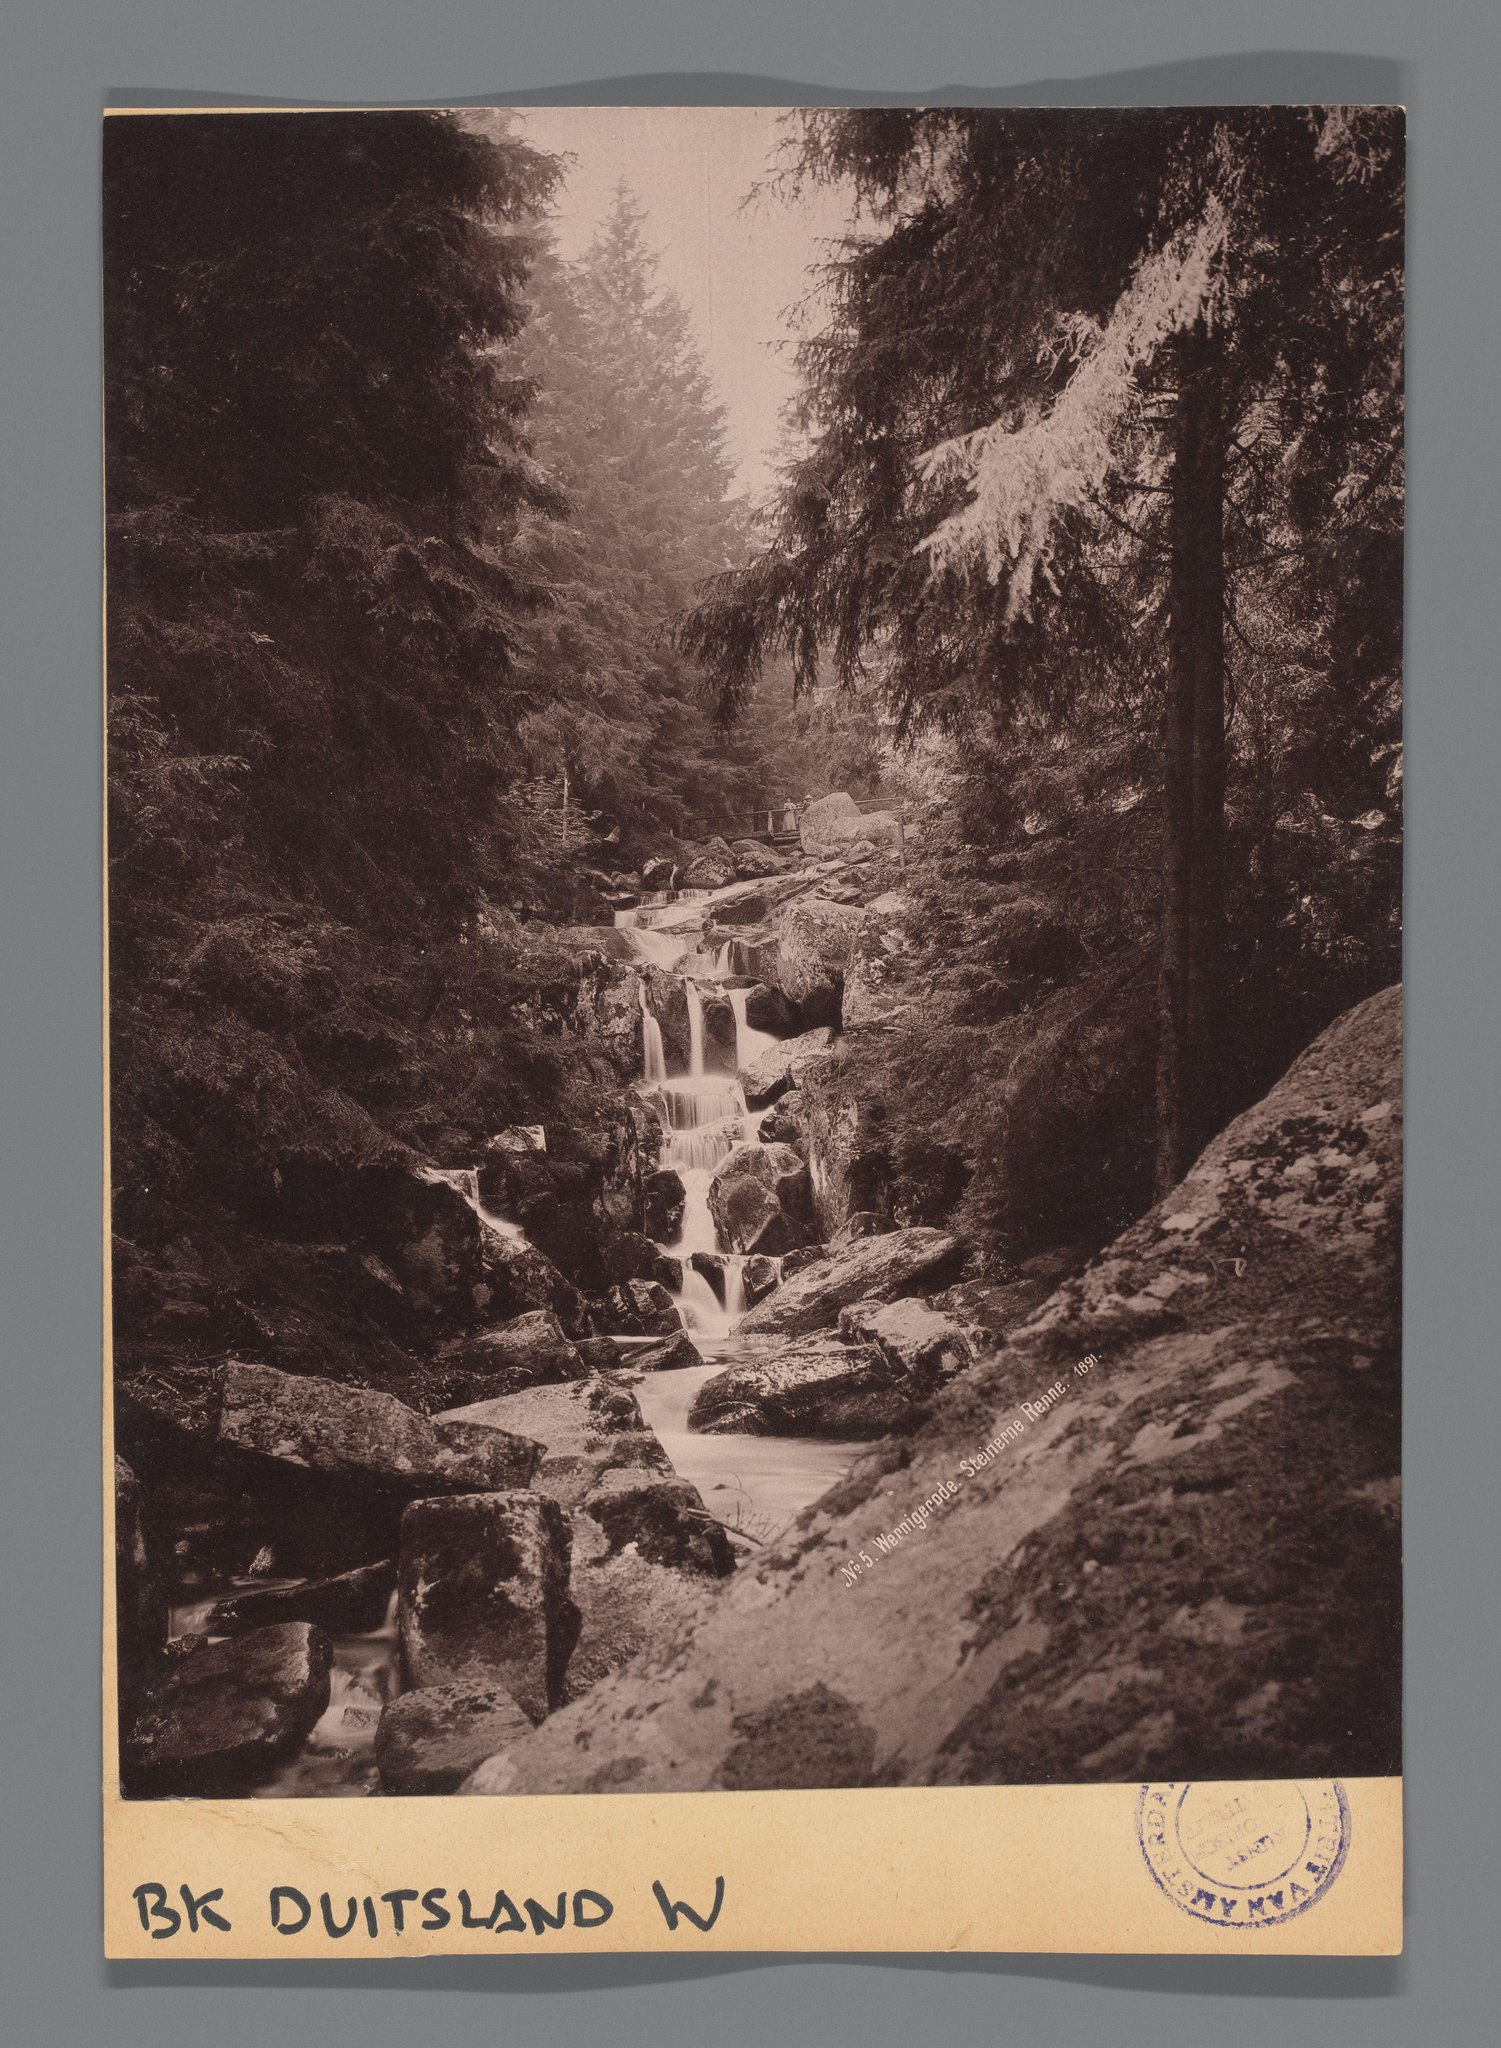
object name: photograph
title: Wernigerode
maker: Anonymous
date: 1880-1920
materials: cardboard, photographic support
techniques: photograph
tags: germany